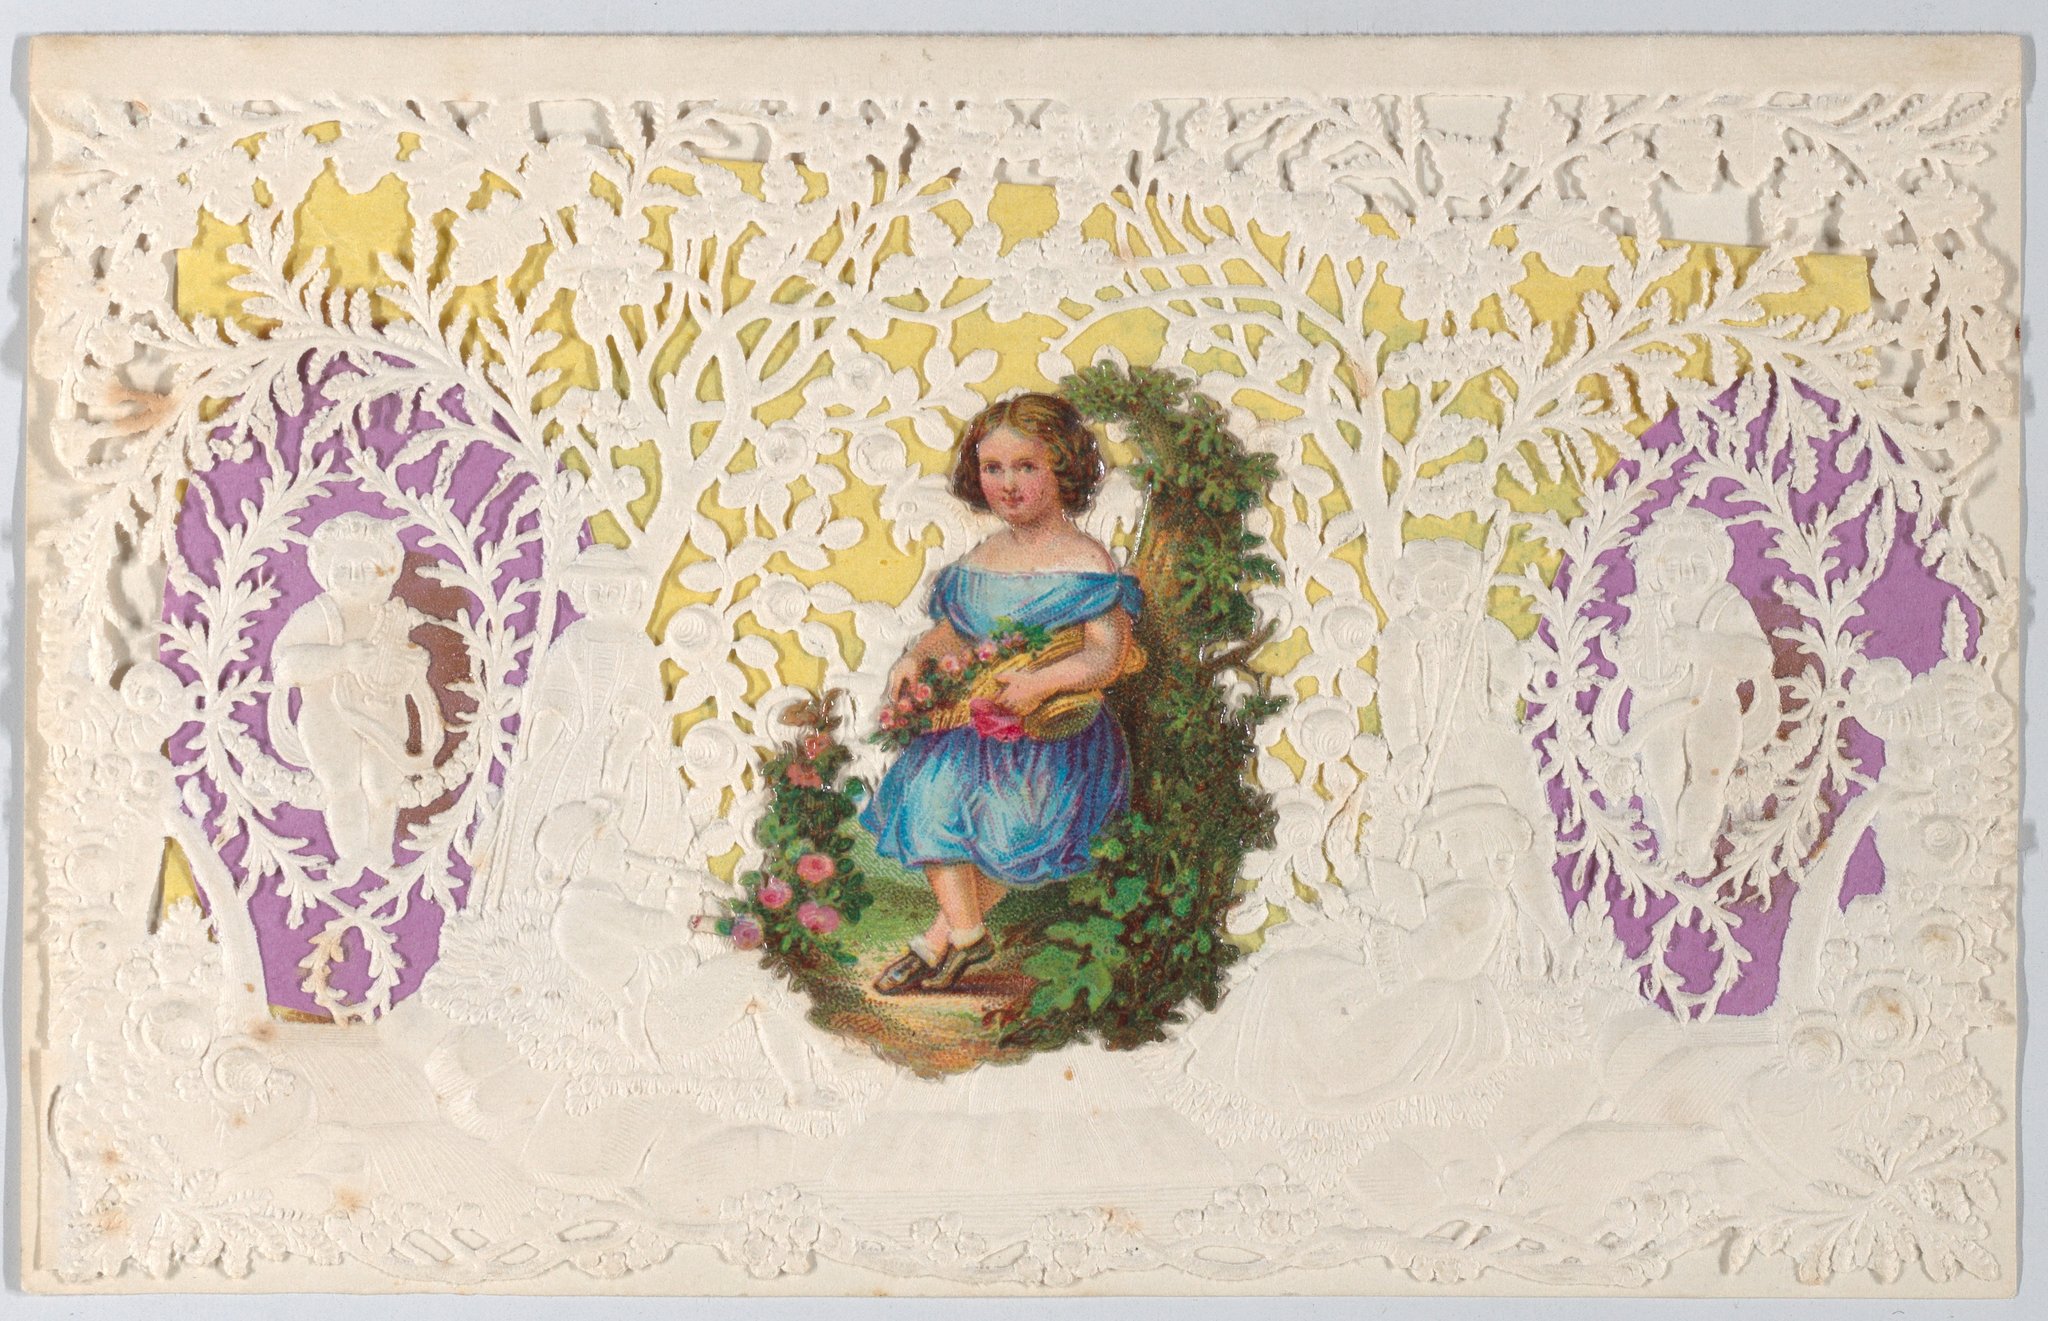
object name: valentine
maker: Anonymous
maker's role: artist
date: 1850-1870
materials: ink, lace, paper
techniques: cutting, embossing, open work